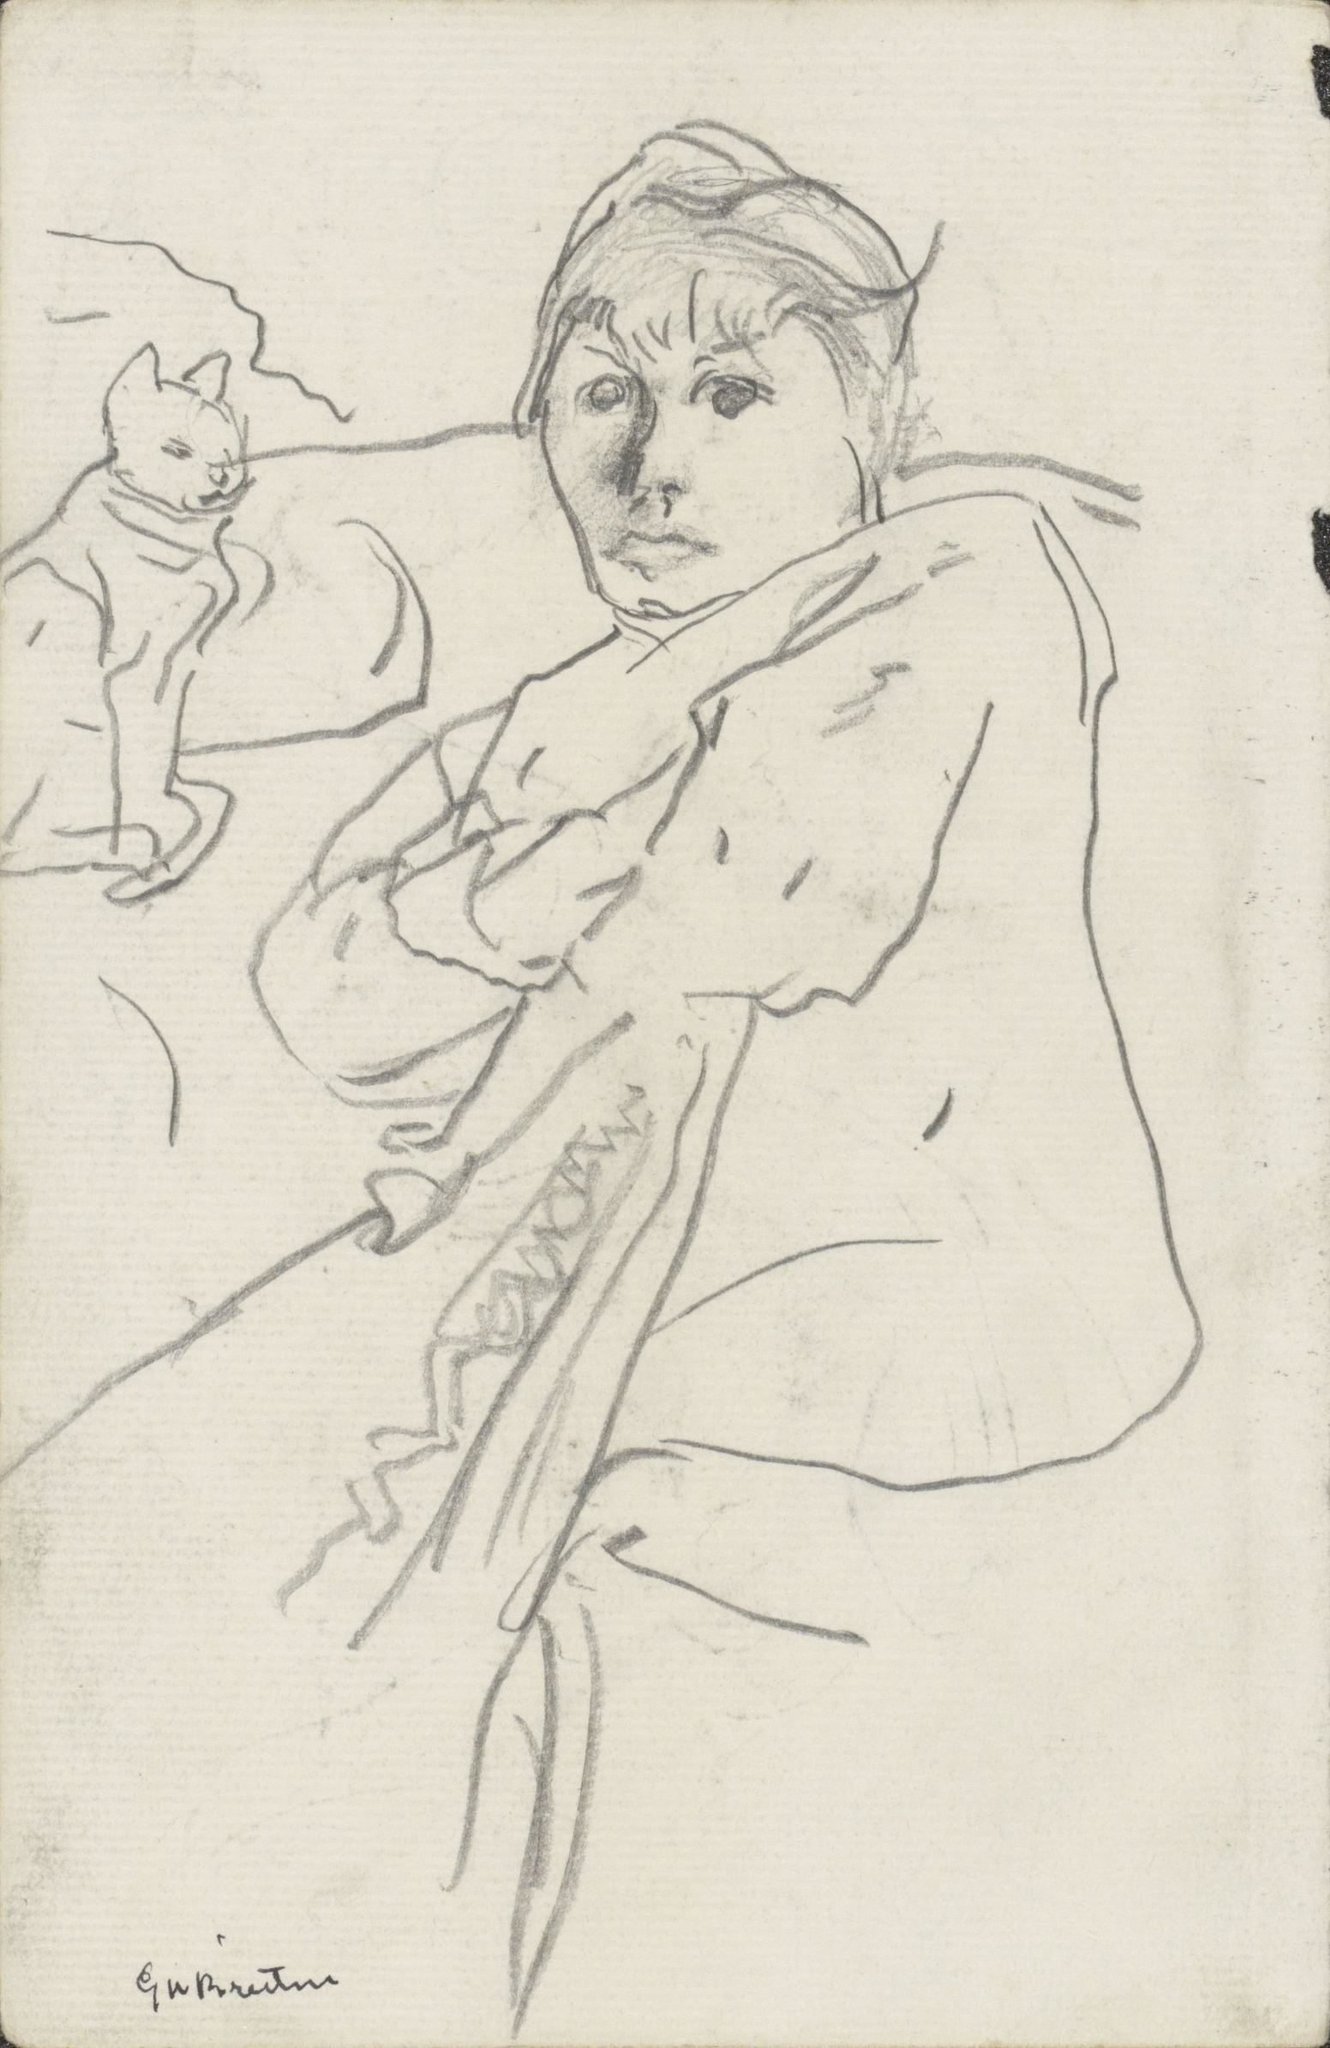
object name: drawing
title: Zittende vrouw met kat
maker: george hendrik breitner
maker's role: draughtsman, painter, print maker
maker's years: 1857-1923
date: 1912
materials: paper, pencil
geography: amsterdam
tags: cat, adult woman (+ sitting), anonymous historical person portrayed - bb - woman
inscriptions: signature: ‘G H Breitner’